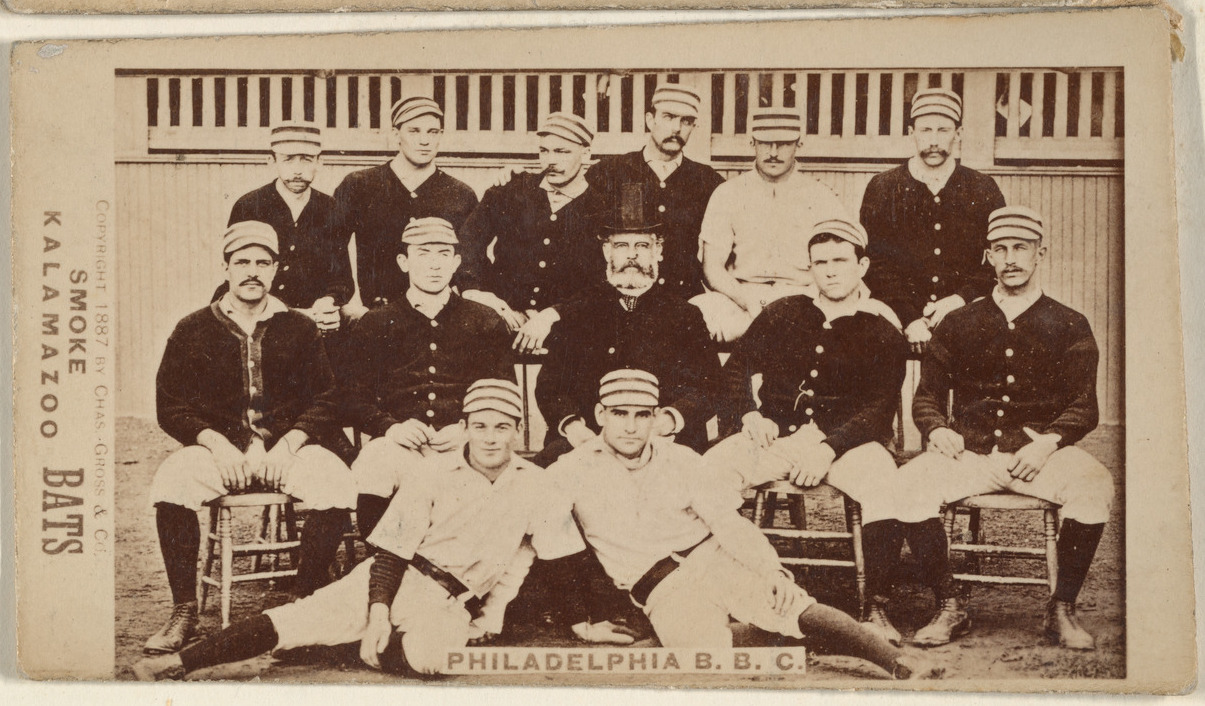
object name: baseball card, photograph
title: Philadelphia Team, from the Kalamazoo Bats series (N690) issued by Chas. Gross & Co. to promote Kalamazoo Bats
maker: chas. gross & co.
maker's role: publisher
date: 1887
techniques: albumen silver print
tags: men,portraits,baseball,athletes